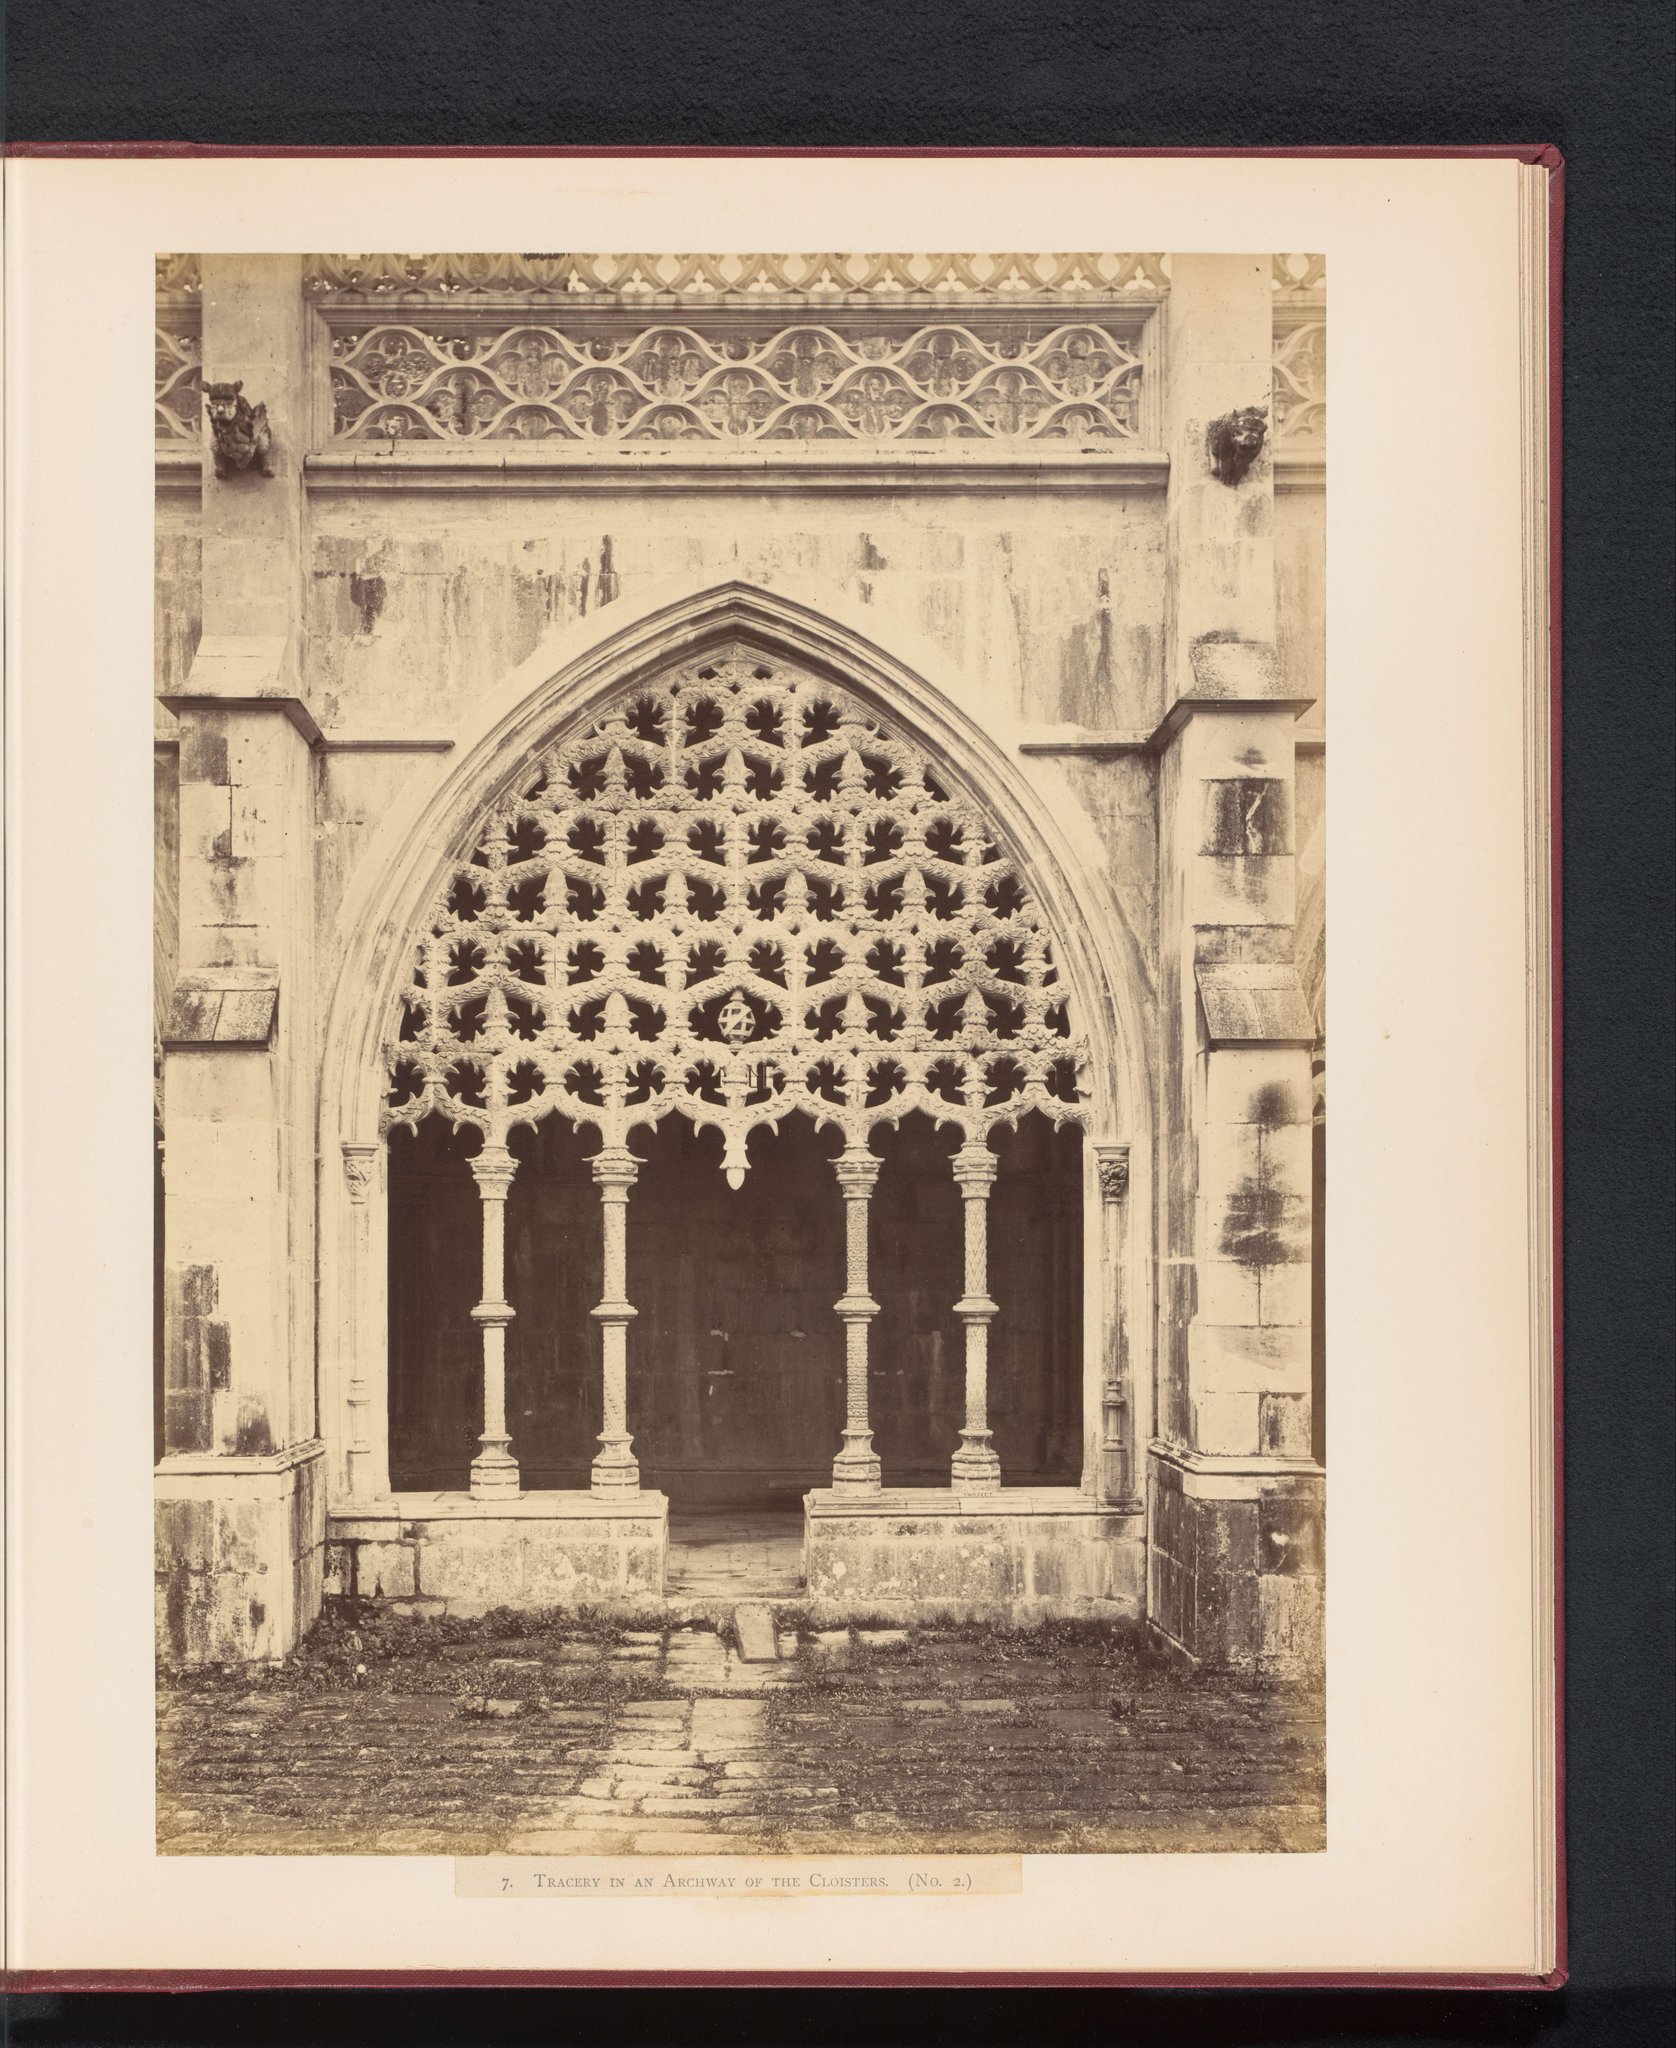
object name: page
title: Ornamentiek in één van de bogen van het klooster van Batalha, Portugal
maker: charles thurston thompson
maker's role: fotograaf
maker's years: 1816-1868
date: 1863-1868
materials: photographic support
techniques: albumen print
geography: batalha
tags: ornament ~ tracery, cloisters ~ monastery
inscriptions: number: ‘7.’